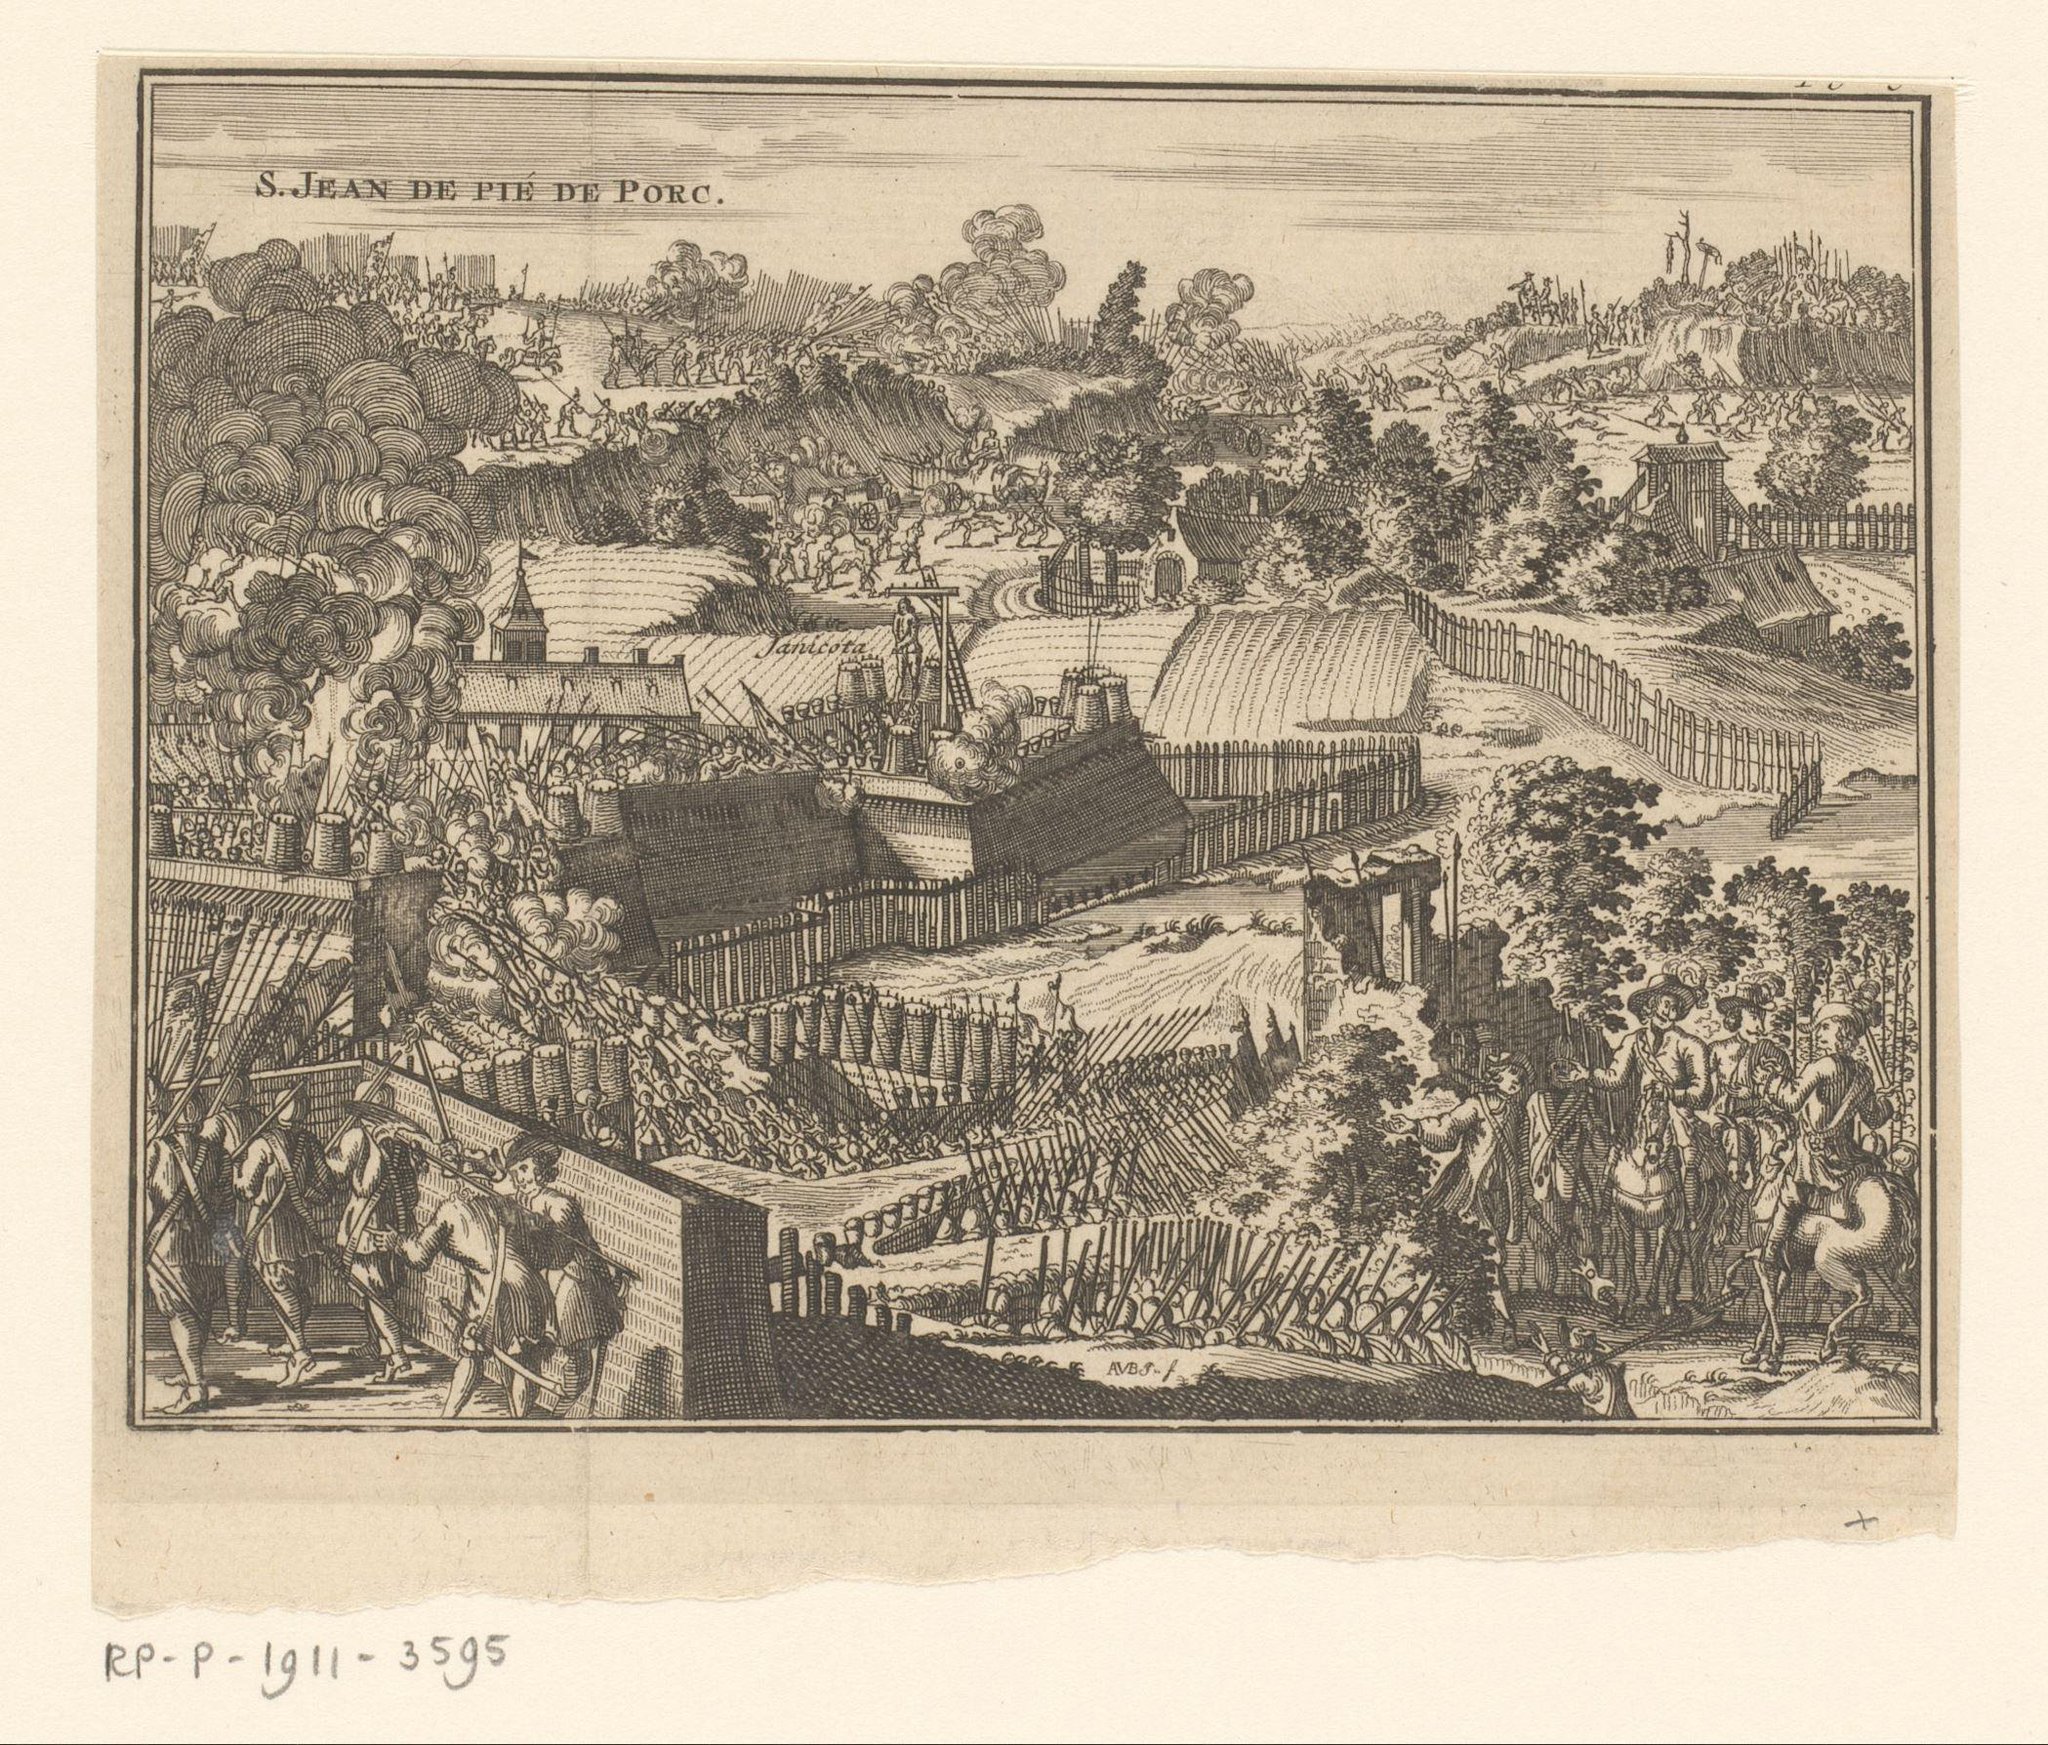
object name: print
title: Verovering van Saint-Jean-Pied-De-Port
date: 1680-1780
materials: paper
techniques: etching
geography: low countries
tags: battle (+ during the battle)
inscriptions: collector's mark: Lugt 2228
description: Soldaten strijden tegen elkaar bij de stadsmuur van Saint-Jean-Pied-De-Port. Rechtsvoor enkele mannen te paard.